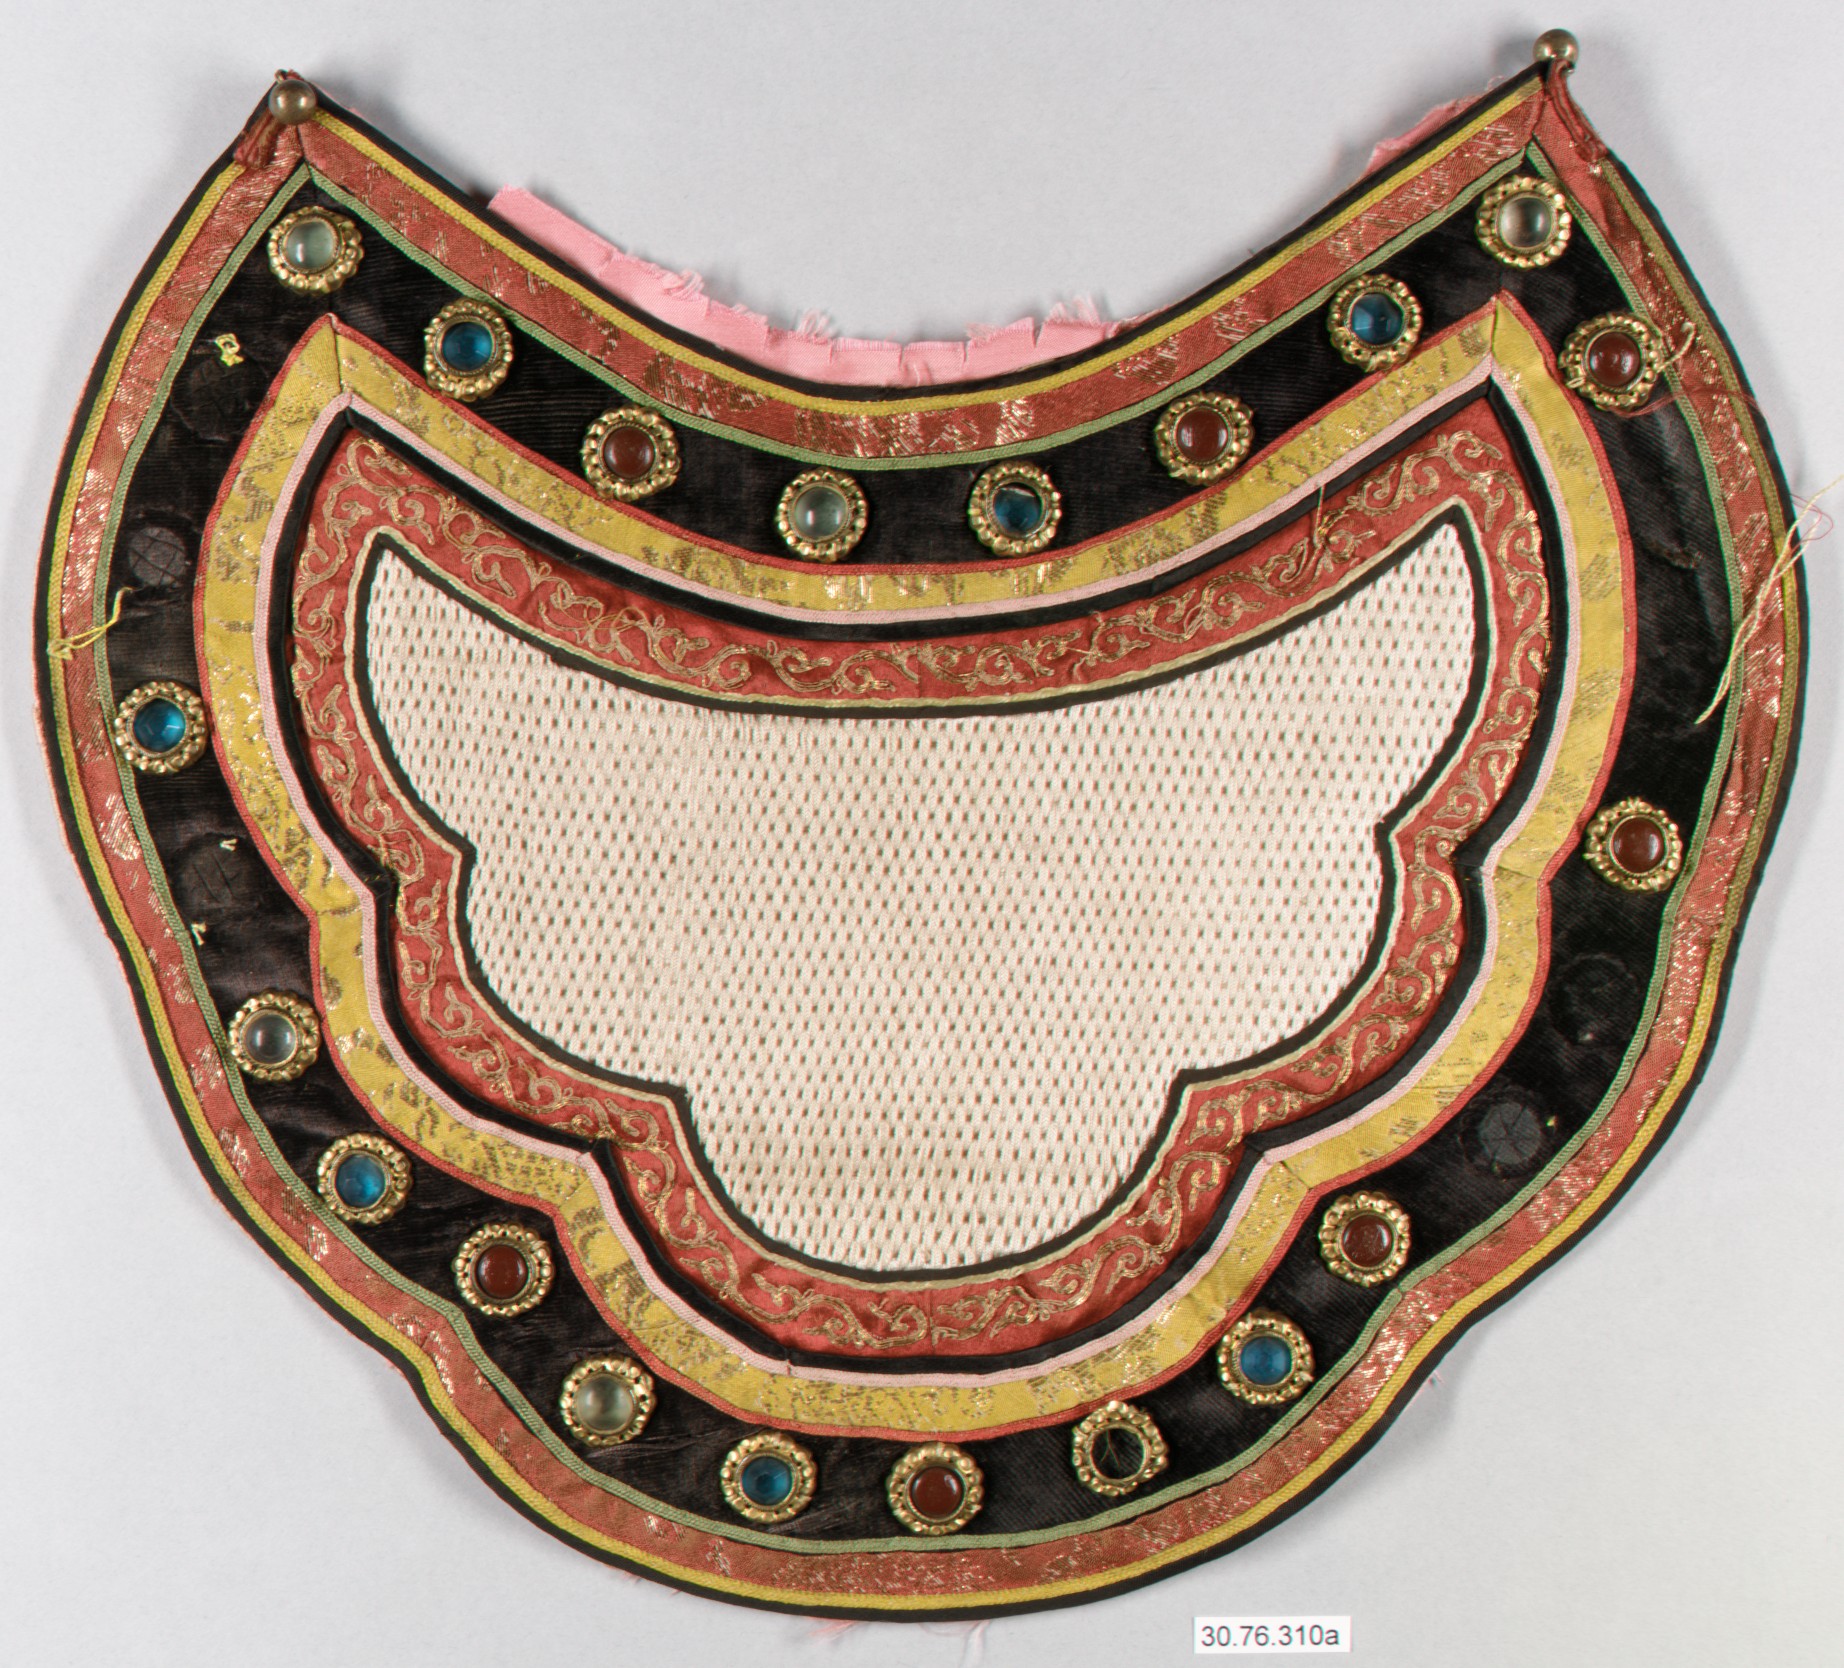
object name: imperial theatrical warrior's coat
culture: chinese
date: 1701-1800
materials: textile